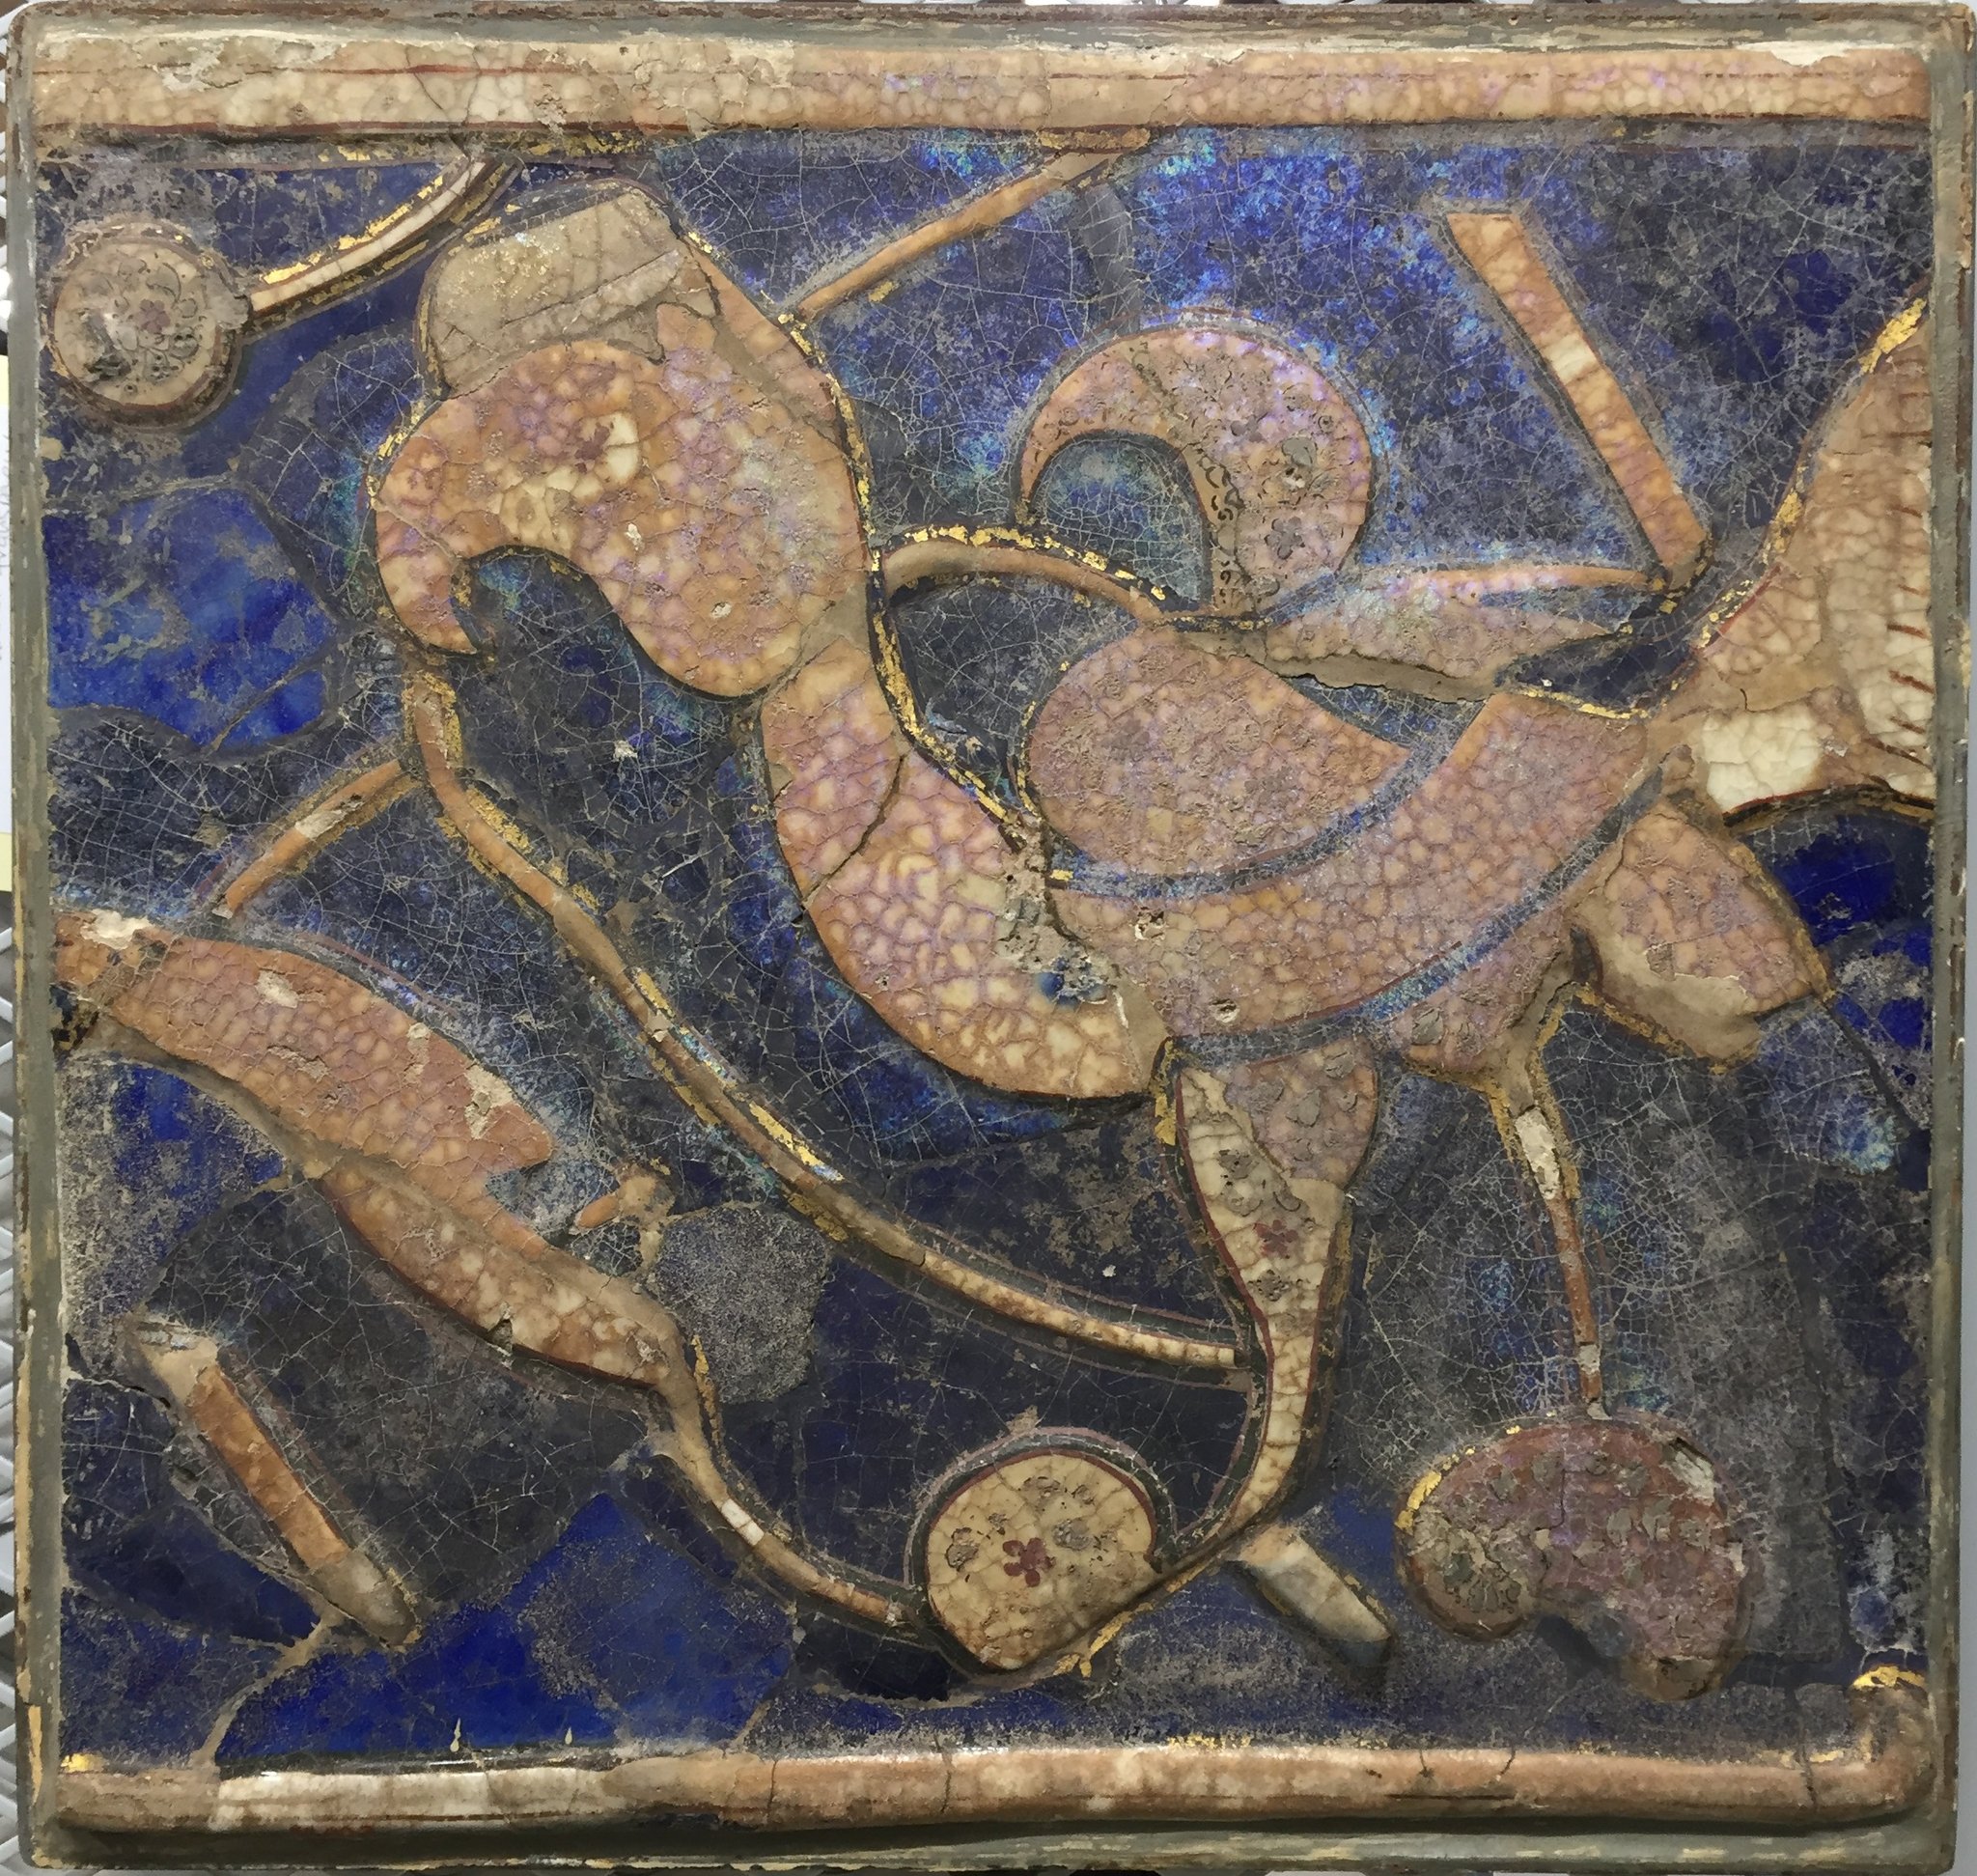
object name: tile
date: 1201-1300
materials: glaze, stonepaste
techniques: painting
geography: iran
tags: birds